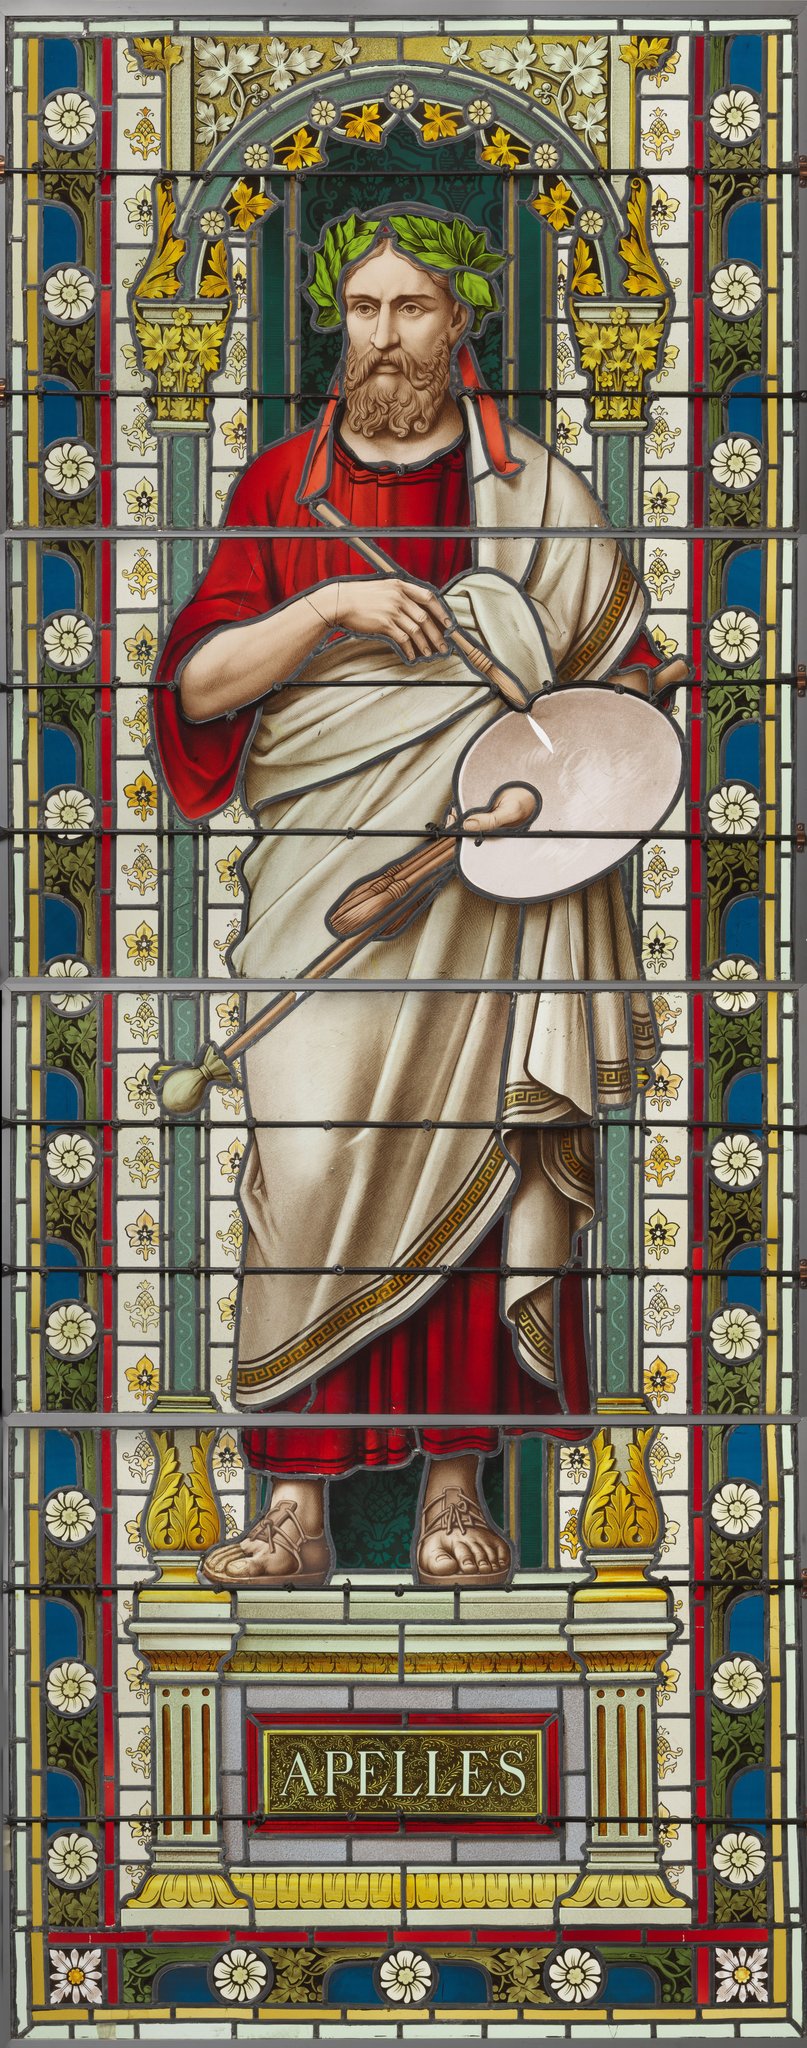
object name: light window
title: Raam met voorstelling Apelles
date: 1882-1883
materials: glass, lead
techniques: enamel painting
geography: antwerp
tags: (story of) apelles, the painter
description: P.J.H. Cuypers schreef in 1882 een prijsvraag uit voor het ontwerpen van gebrandschilderde ramen voor de voorhal van het Rijksmuseum. Hij nodigde zes kunstenaars uit mee te doen en een proefraam met Apelles in te sturen. Vijf van hen gaven hieraan gehoor: W.F. Dixon, H.J.J. Geuer, F. Nicolas, Stalins & Janssens en de Tiroler Glasmalerei und Cathedralenglashuette. Dixon kreeg uiteindelijk de opdracht. Zijn raam werd geplaatst. De vier overige ramen worden bewaard in het Rijksmuseum. Zie ook bij BK-1999-87-A/B/C/E.